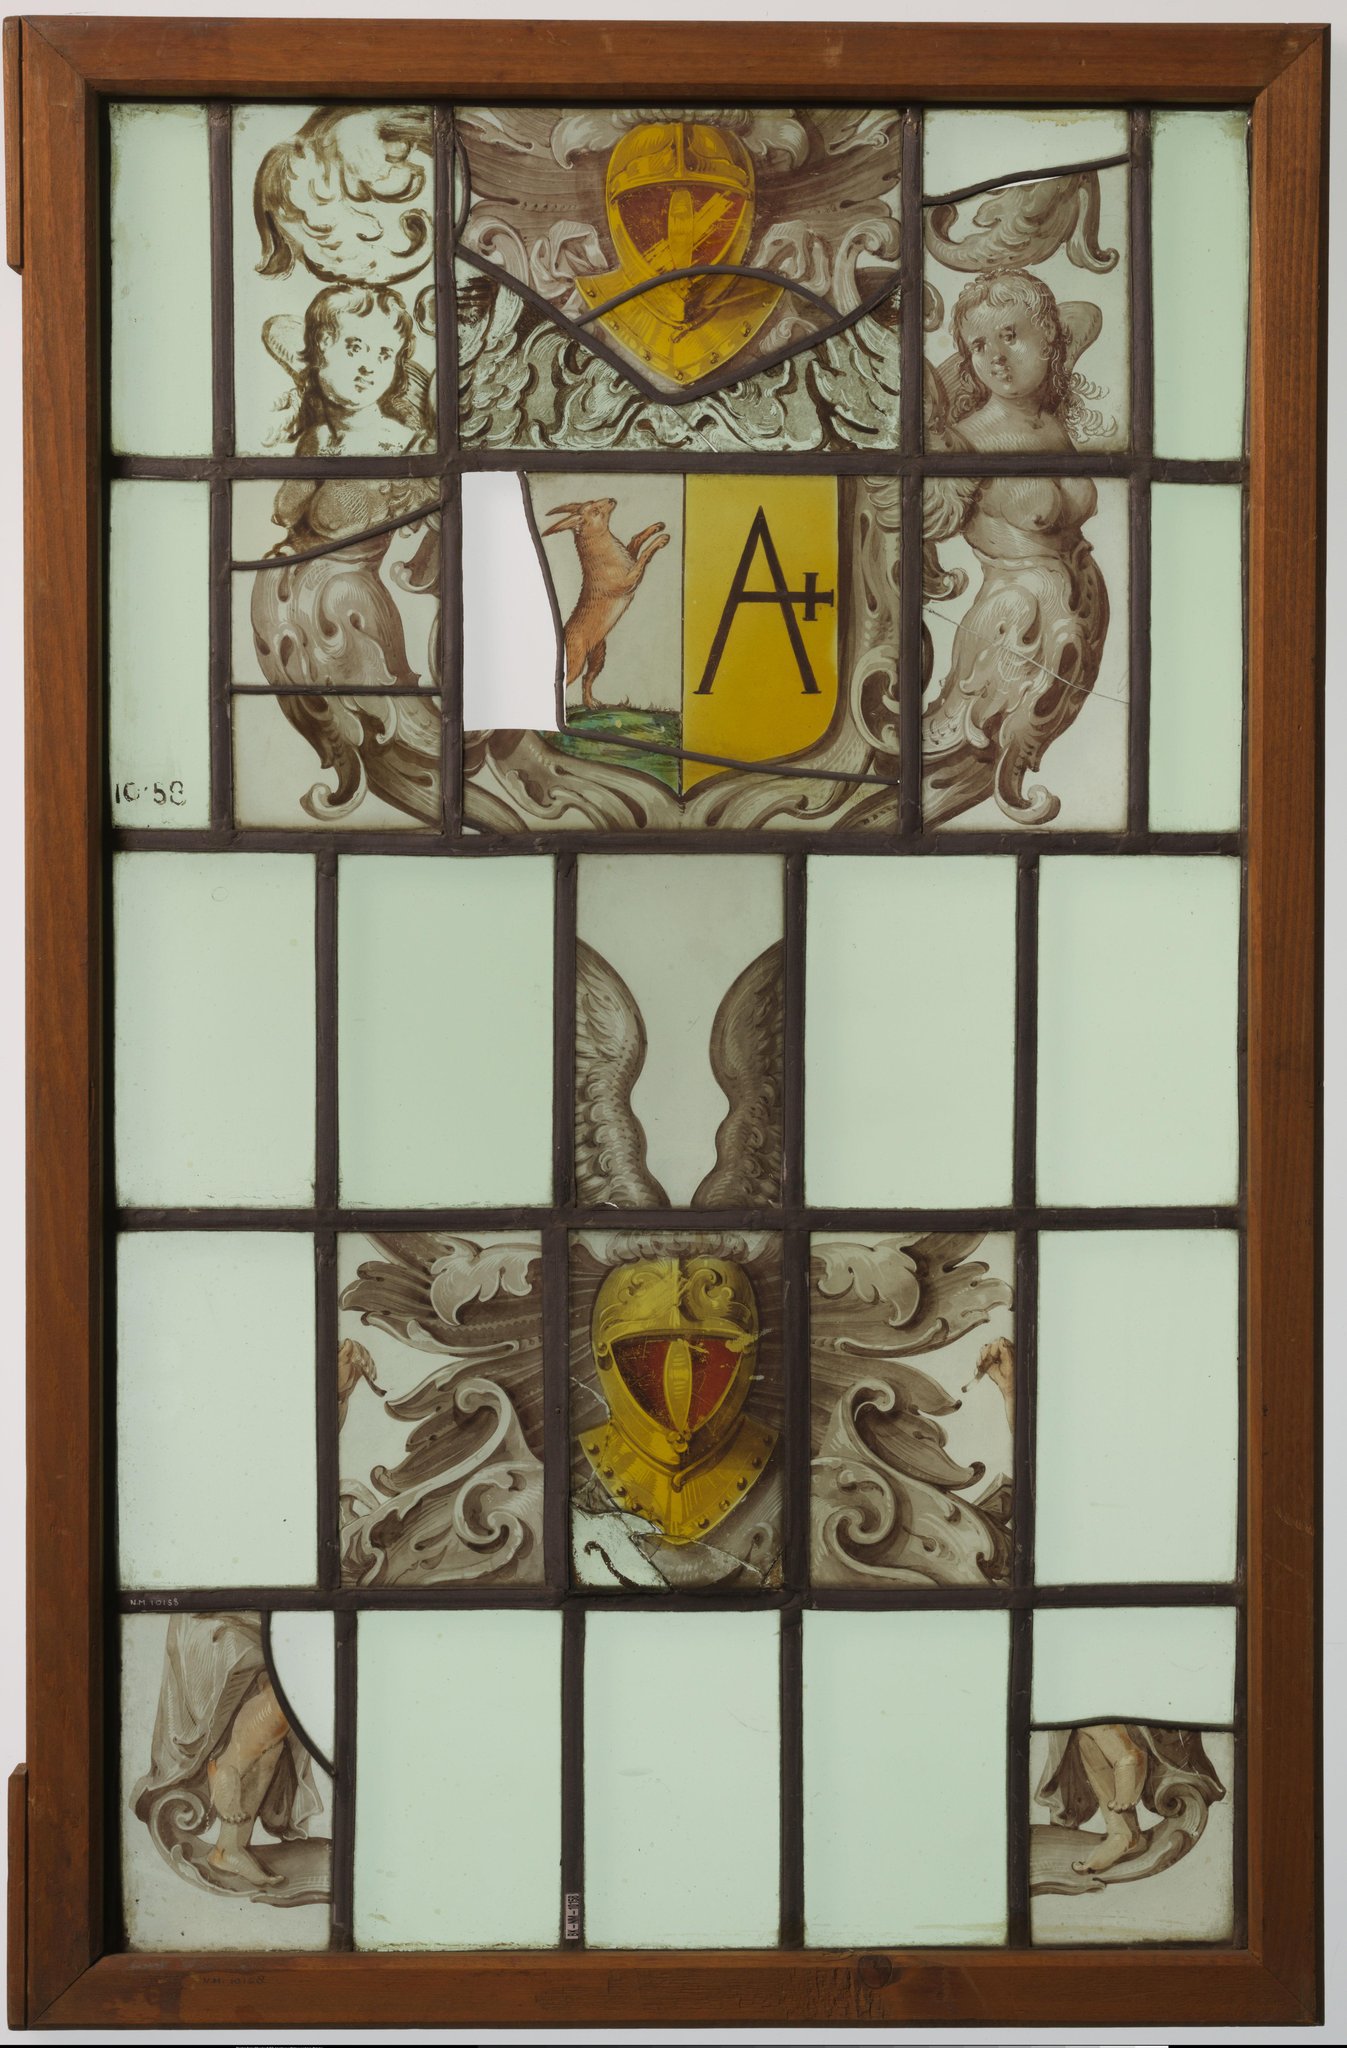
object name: light window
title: Ruit met wapenfragmenten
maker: Anonymous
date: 1700-1800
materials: glass, lead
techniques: leading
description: Een ruit met twee wapens. Van het onderste wapen ontbreekt het wapenschild. In het (gedeelde) wapenschild van het bovenste wapen de letter A en een klimmende haas.